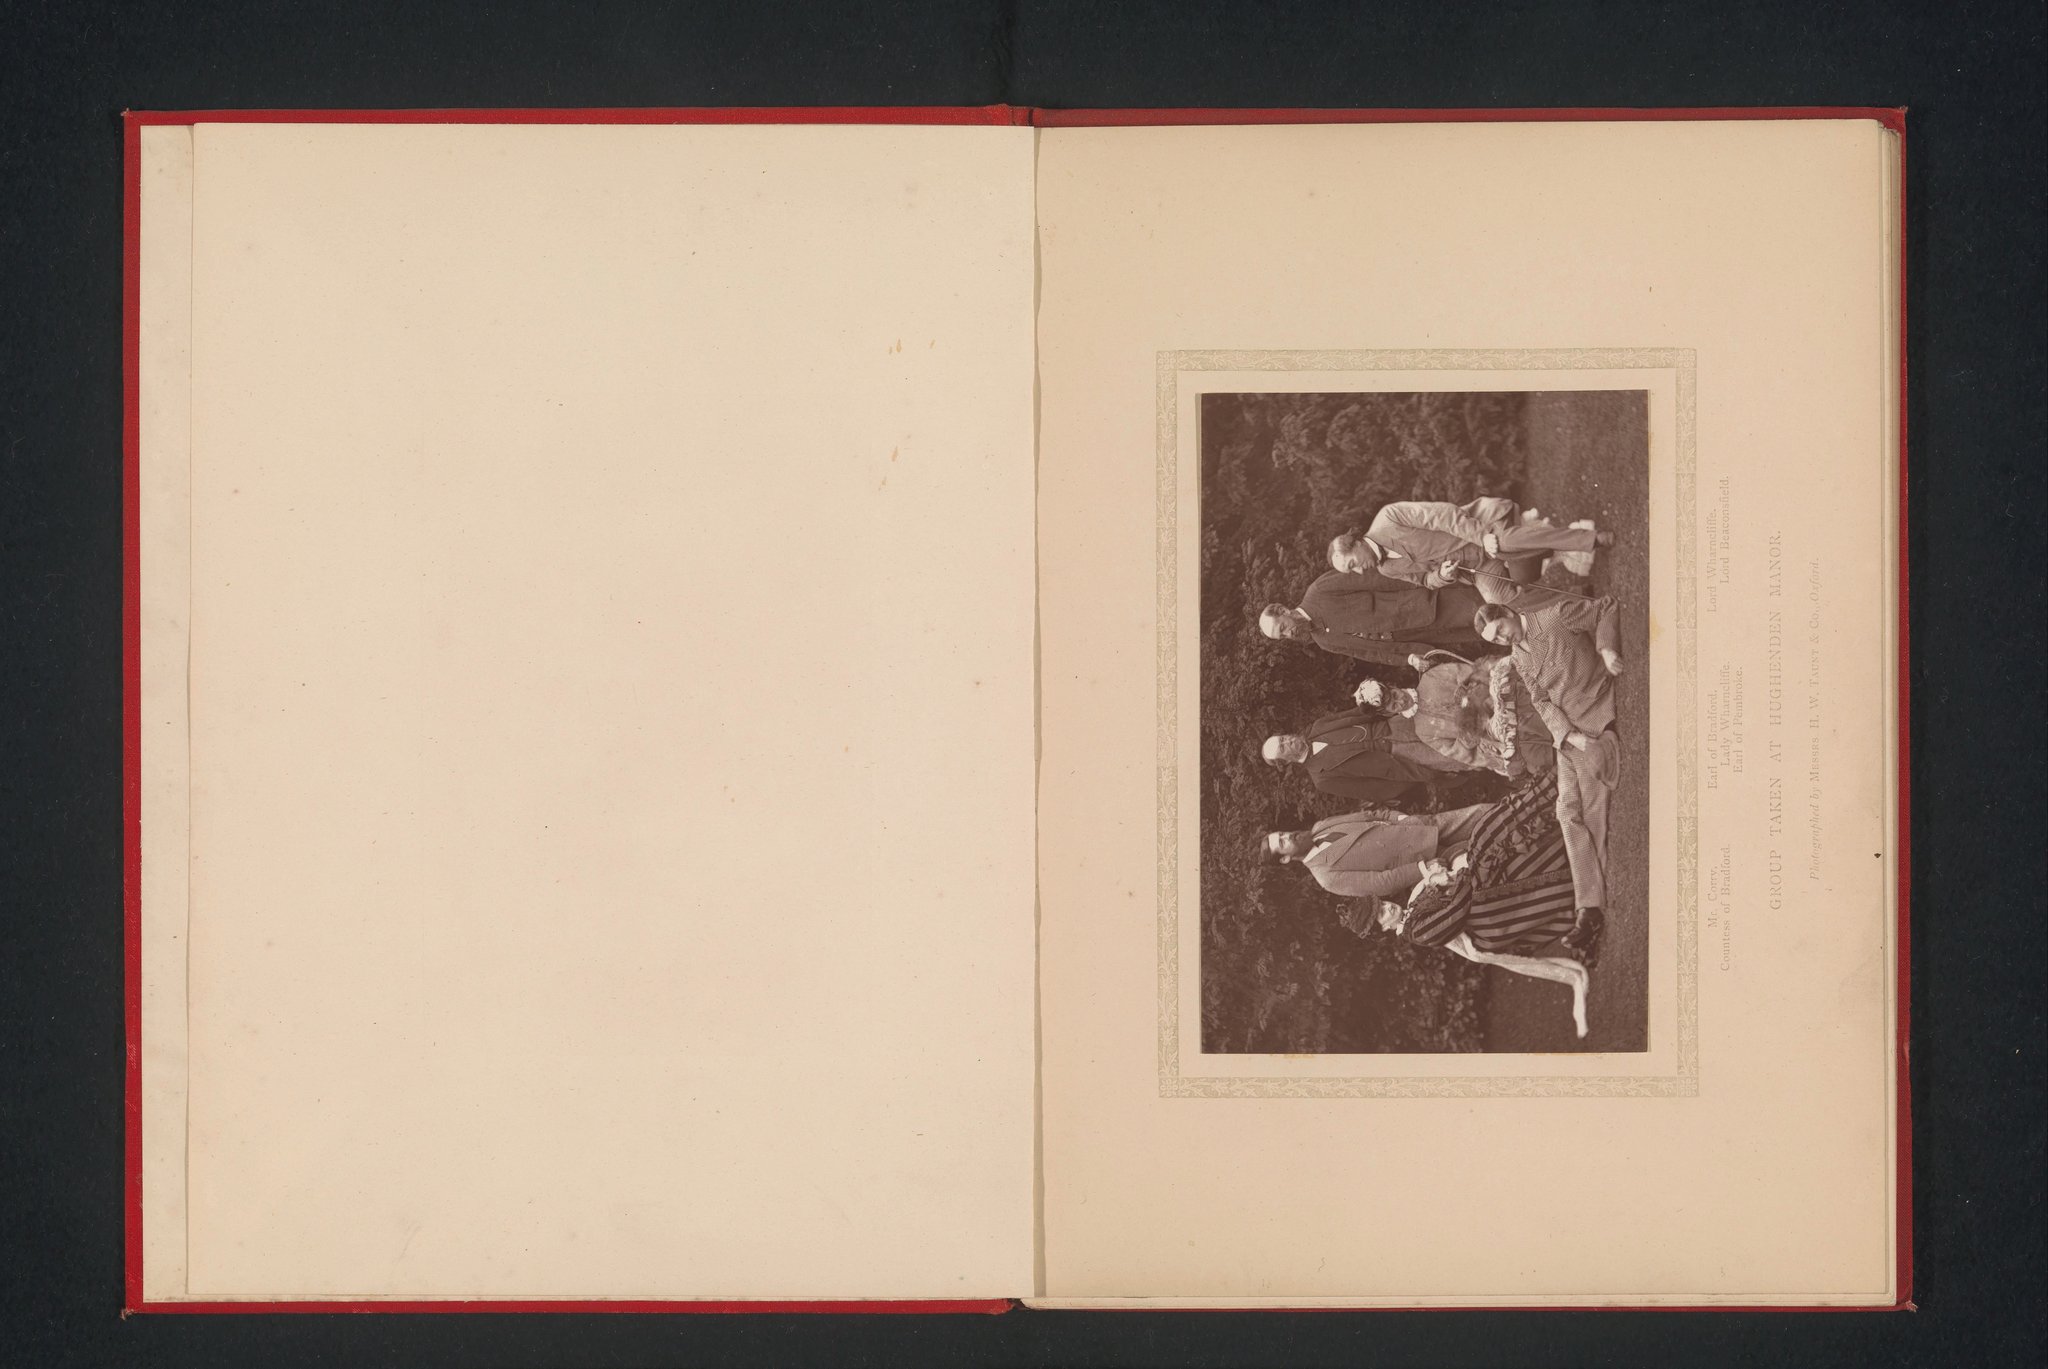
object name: photomechanical print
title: Group taken at Hughenden Manor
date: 1871-1881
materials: paper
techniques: woodburytype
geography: high wycombe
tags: politician, adult woman, garden, politician, e.g. party leader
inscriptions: inscription: ‘Mr. Corry (...) Lord Beaconfield’